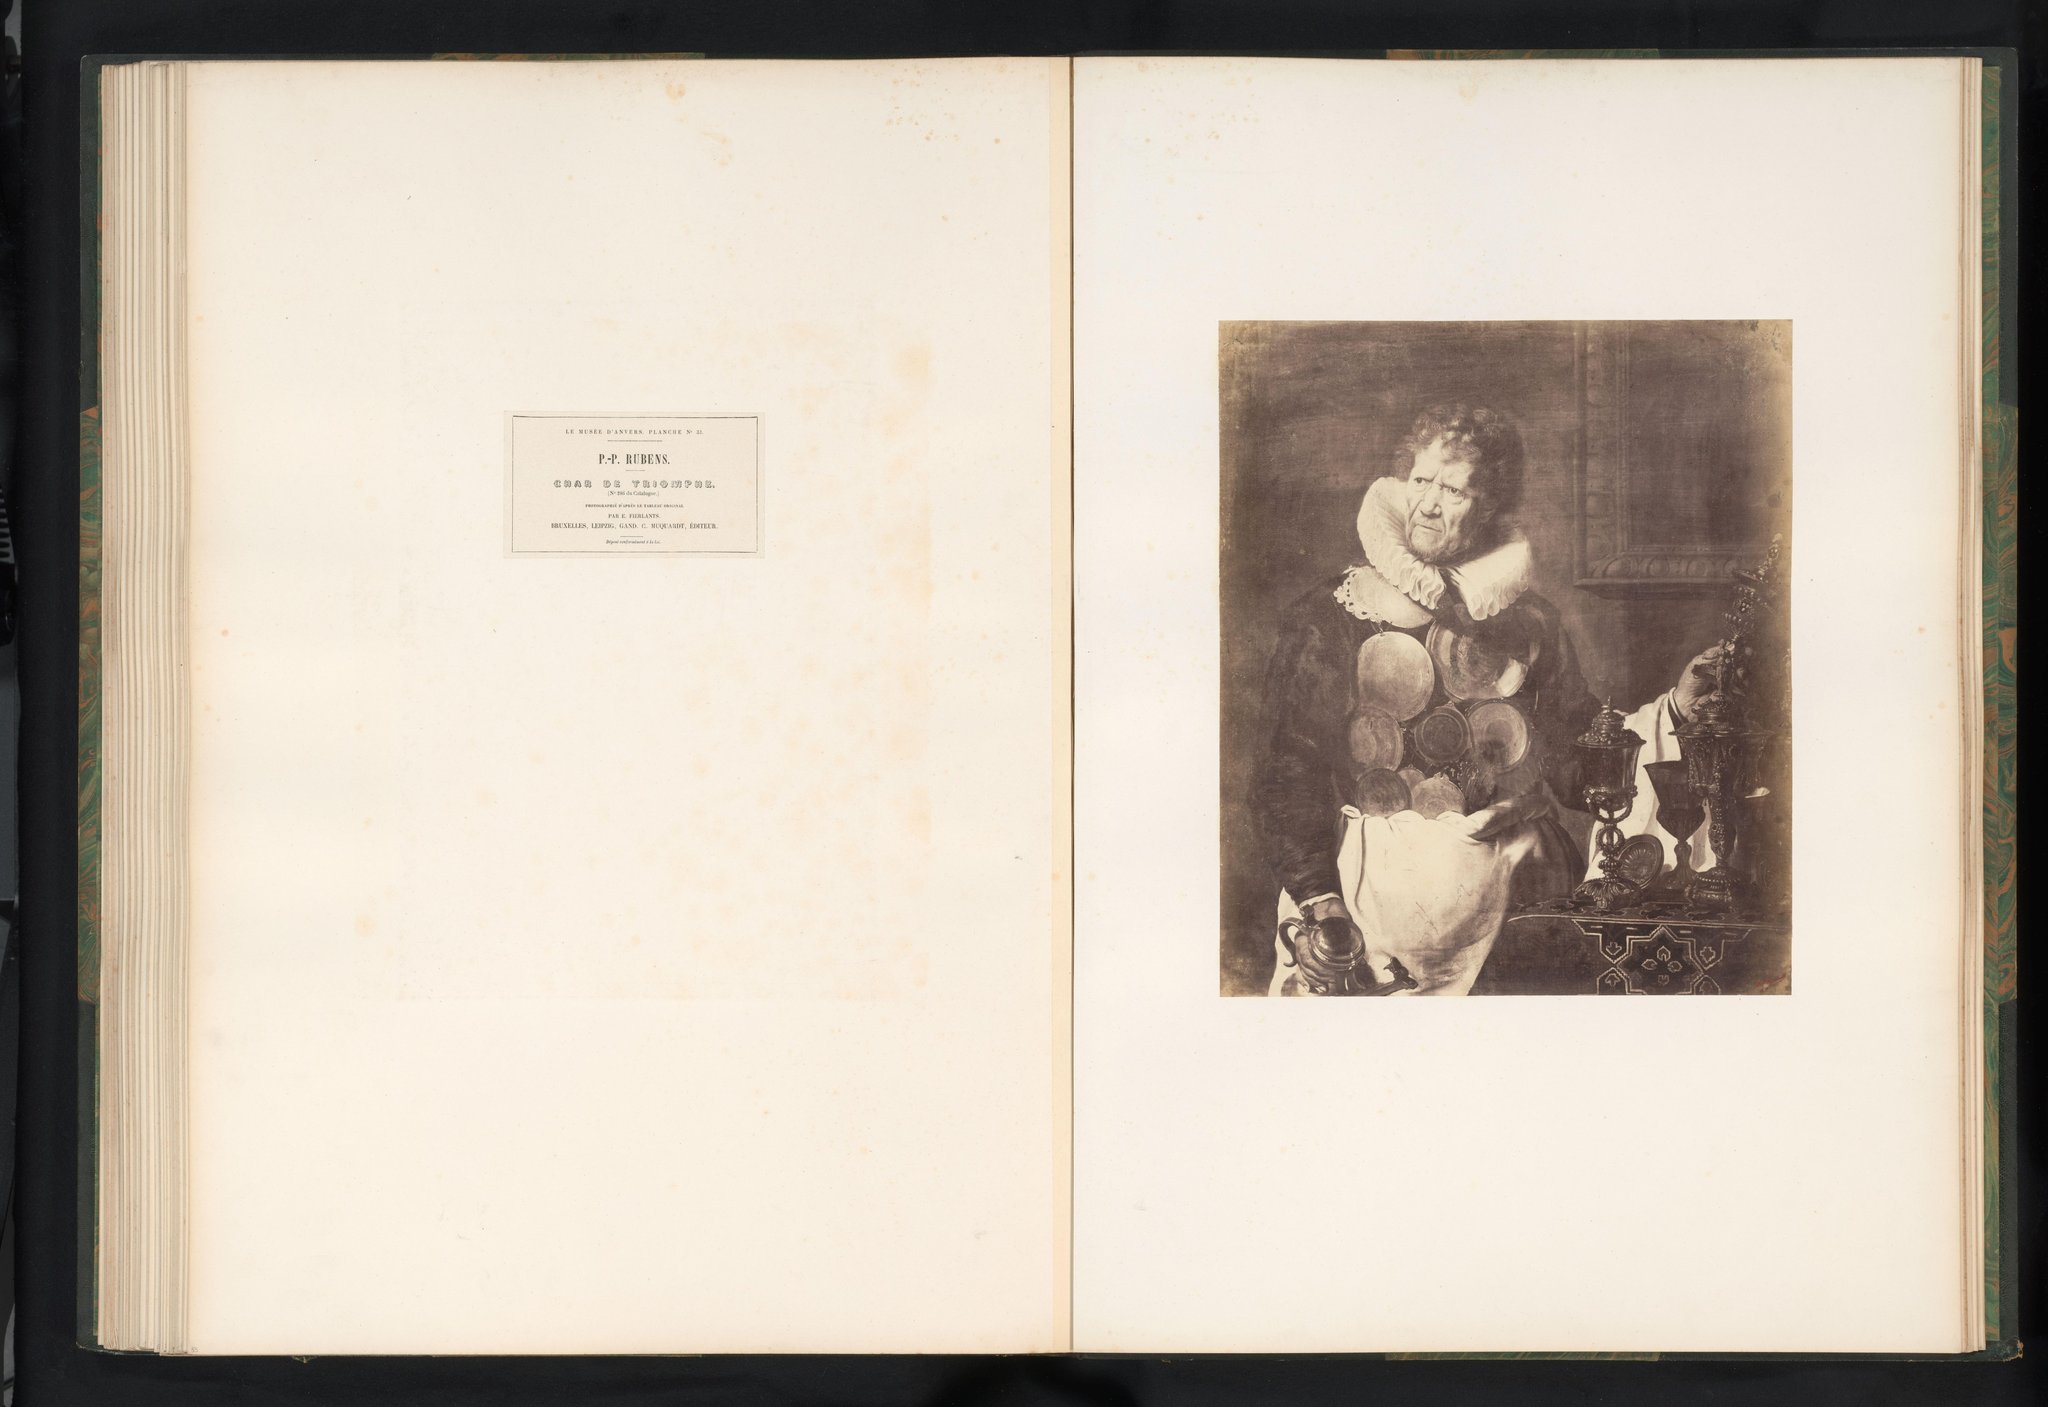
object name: photograph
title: Fotoreproductie van Abraham Grapheus door Cornelis de Vos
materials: photographic support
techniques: albumen print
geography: brussels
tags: historical persons